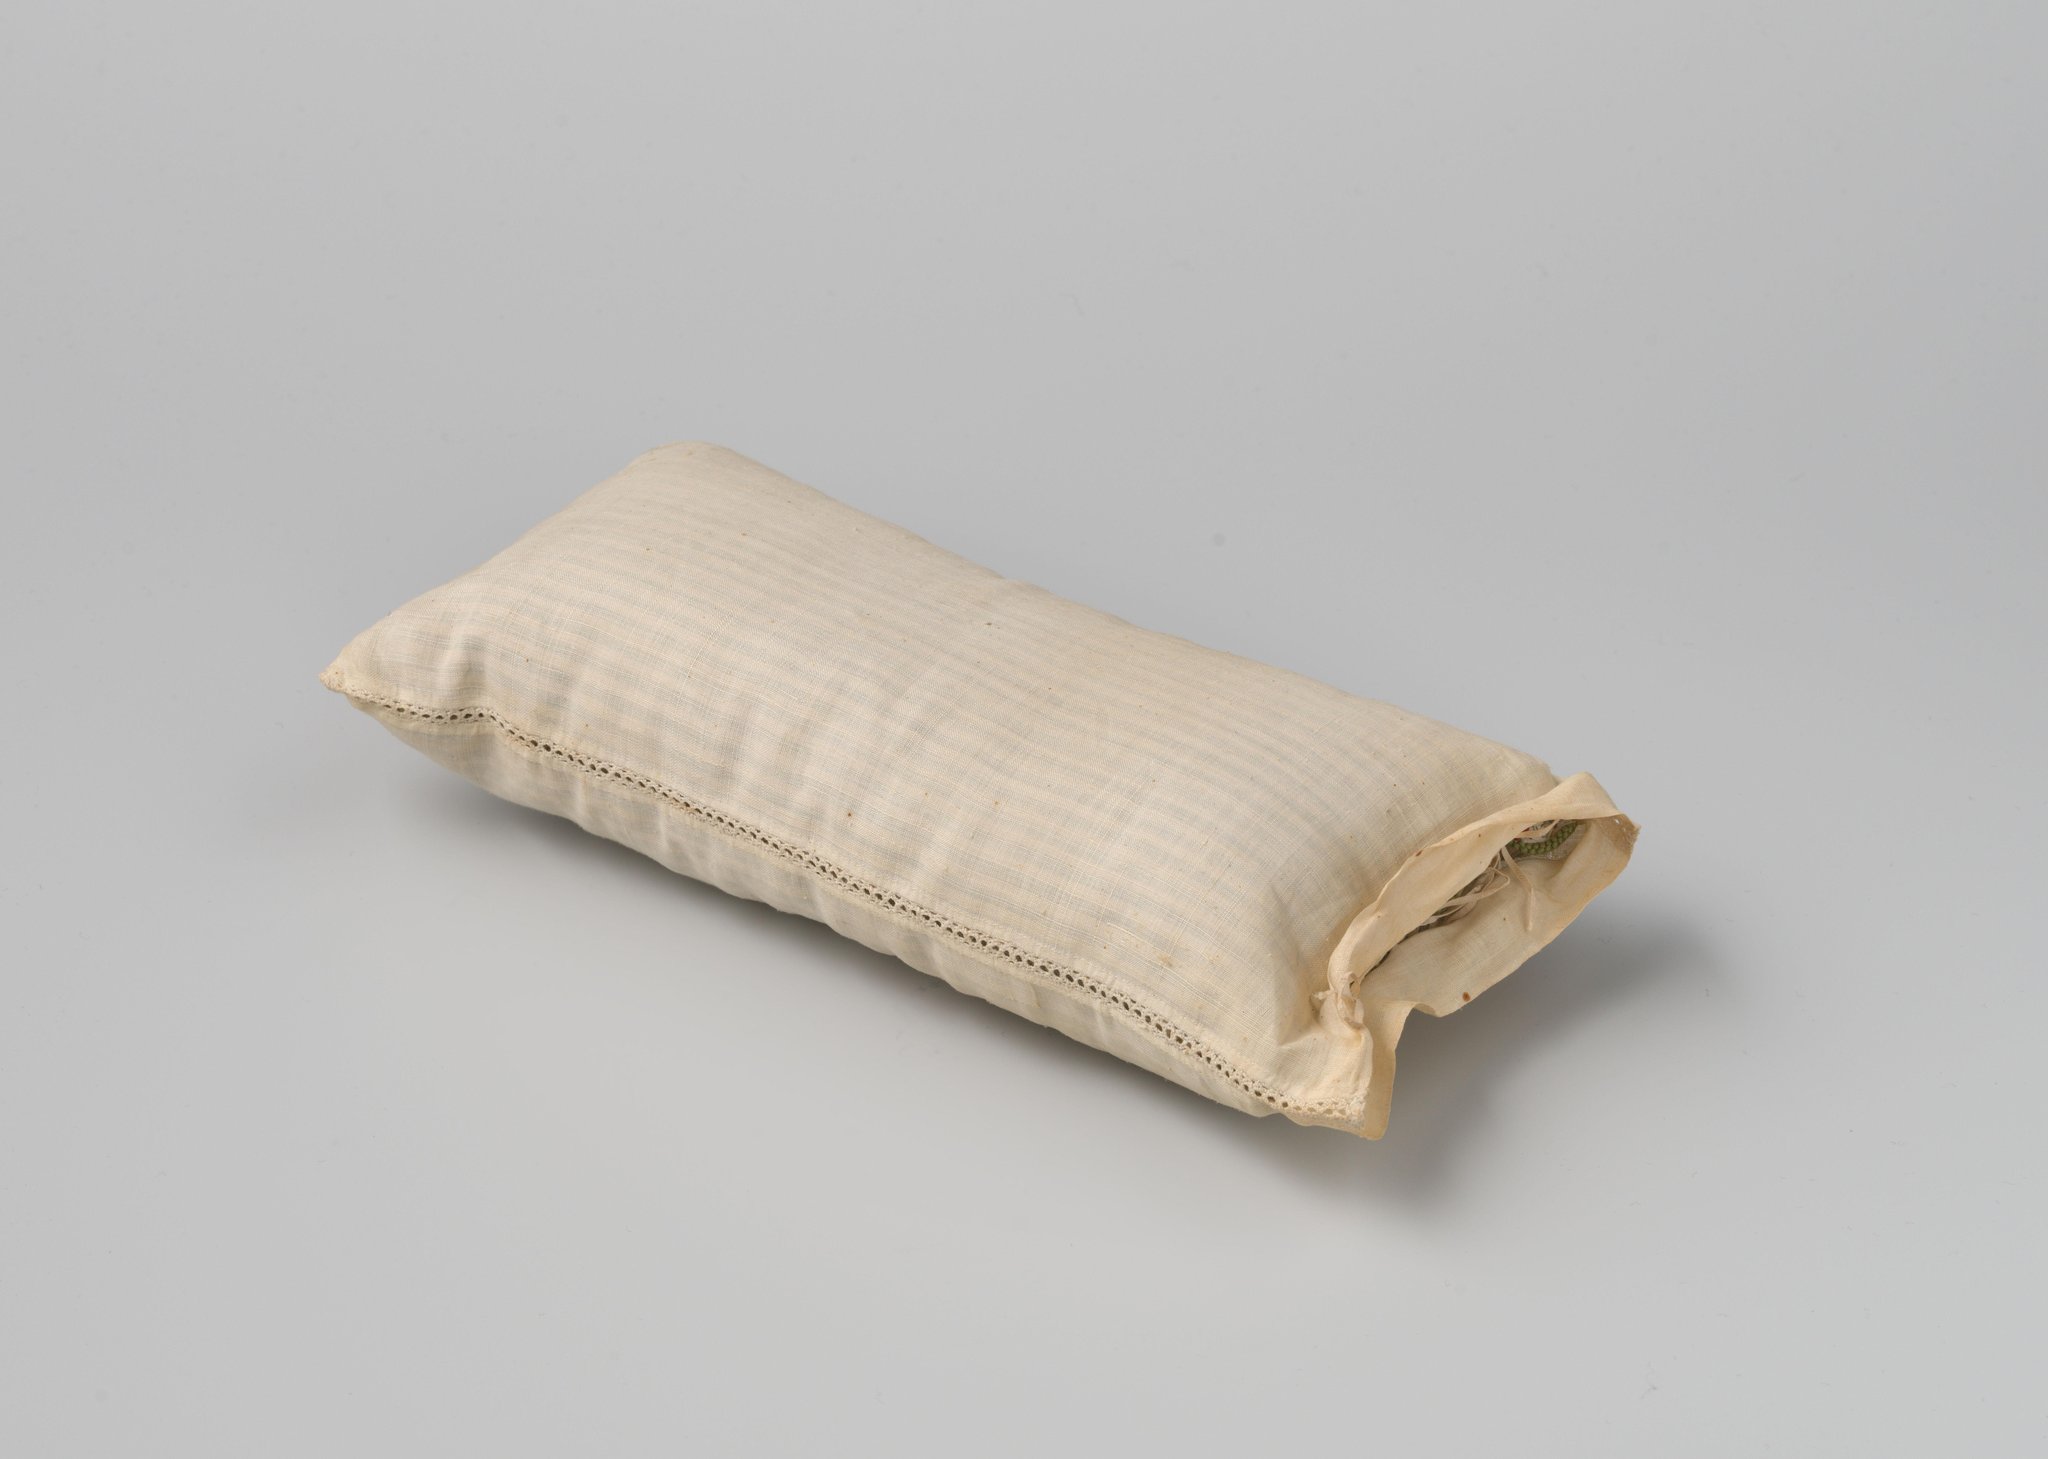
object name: mattress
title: Matras, blauw-wit gestreept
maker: Anonymous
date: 1690-1710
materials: cotton, down, linen, silk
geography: amsterdam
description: Matras van blauw-wit gestreept linnen- en katoenweefsel, omboord met een gevlochten koord van groene zijde. De vulling bestaat uit dons.